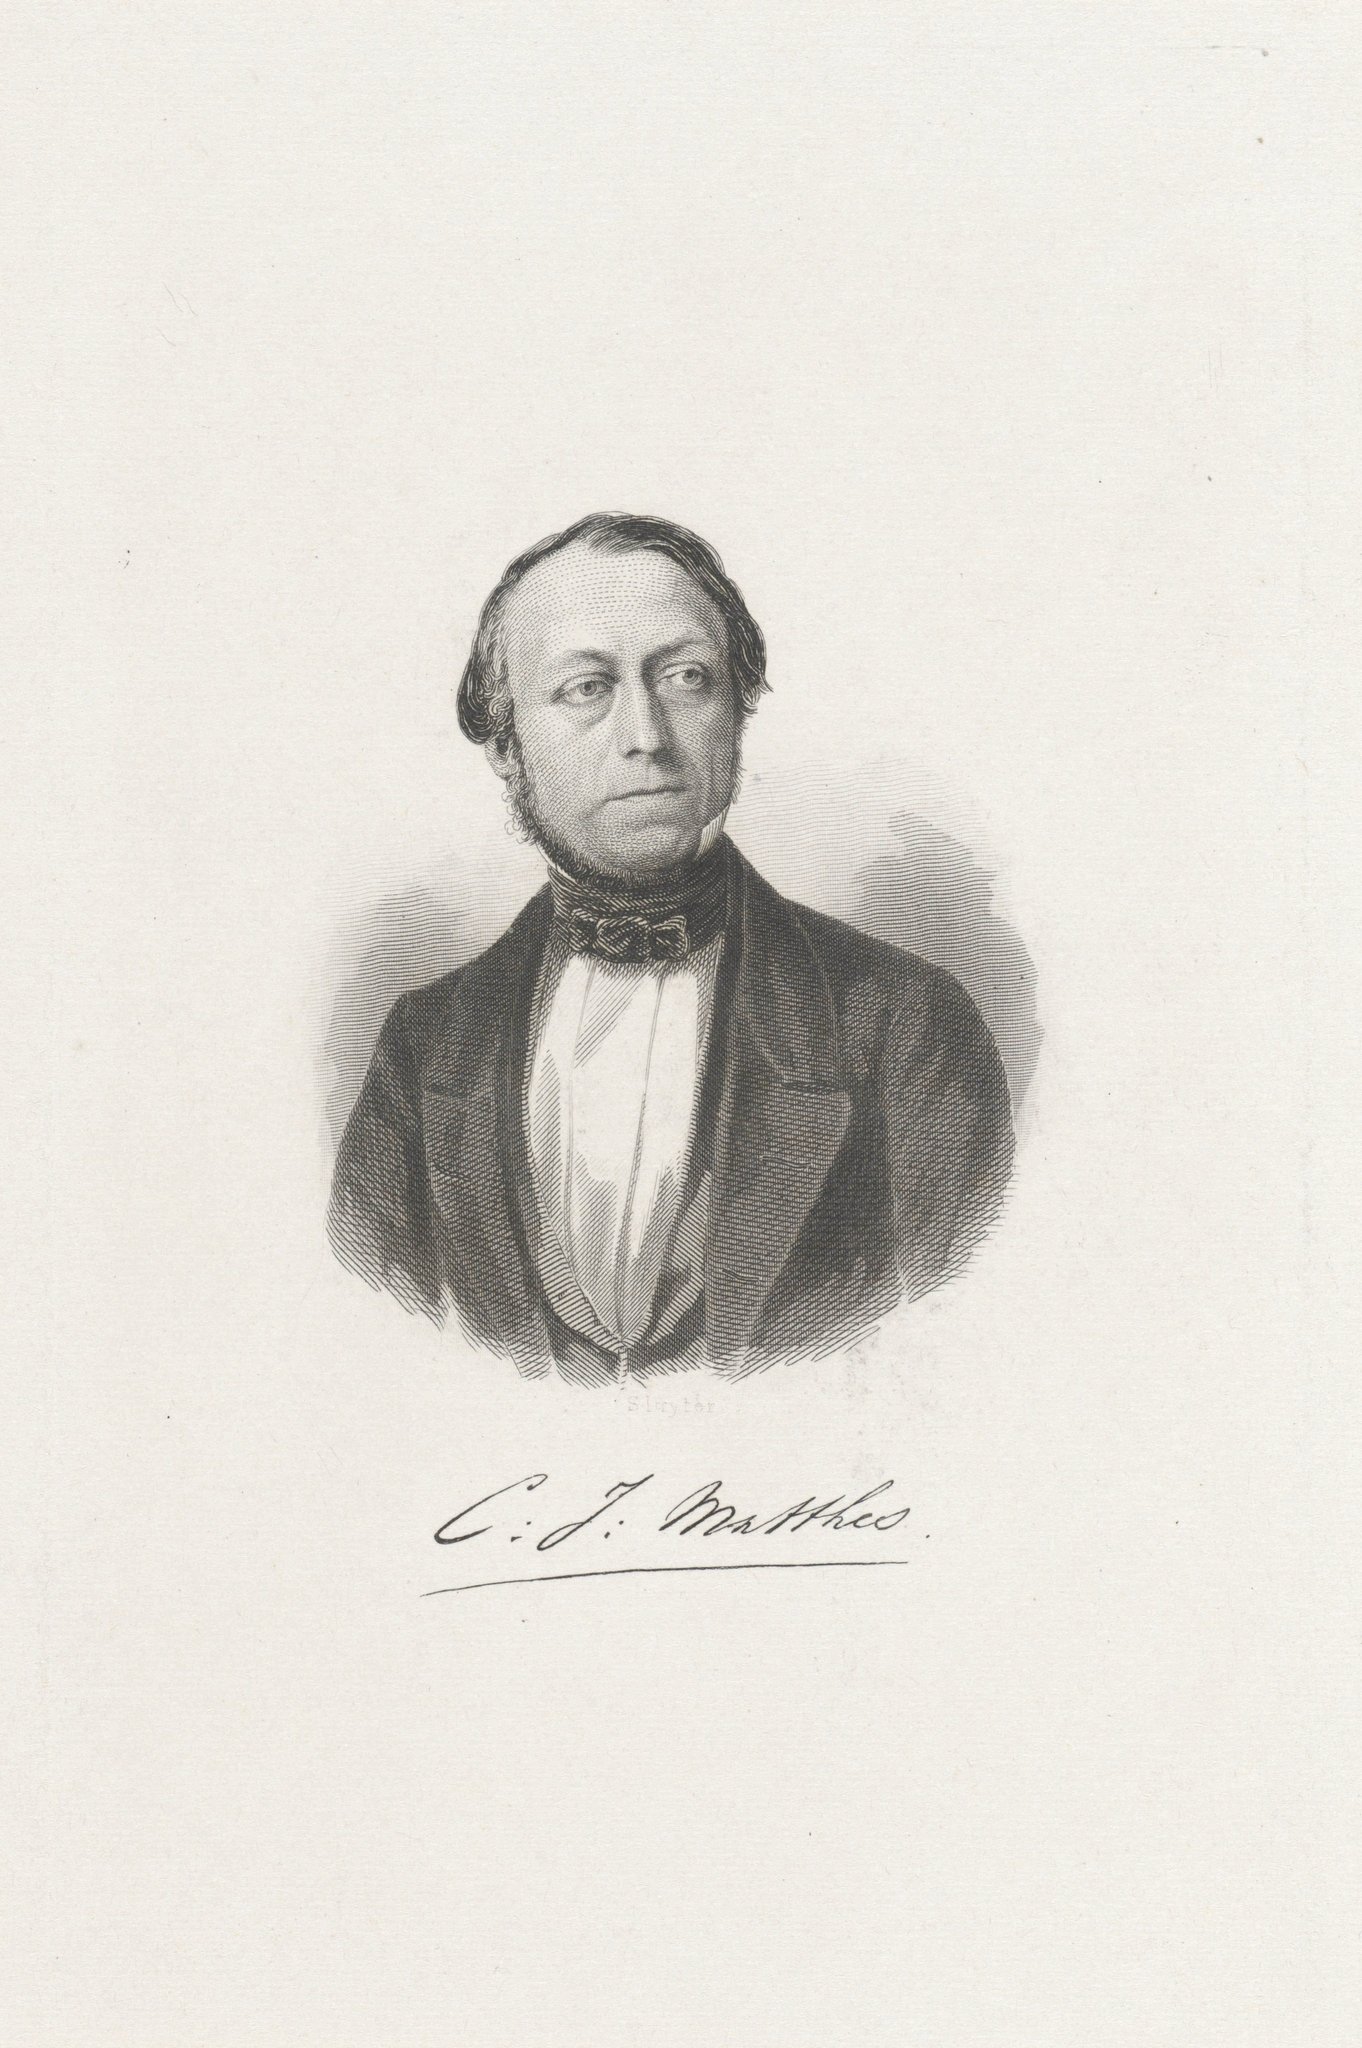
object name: print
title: Portret van de hoogleraar Carel Johannes Matthes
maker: dirk jurriaan sluyter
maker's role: draughtsman, print maker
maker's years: 1811-1886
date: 1830-1886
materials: paper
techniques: etching, engraving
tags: physicist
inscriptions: collector's mark: Lugt 2228